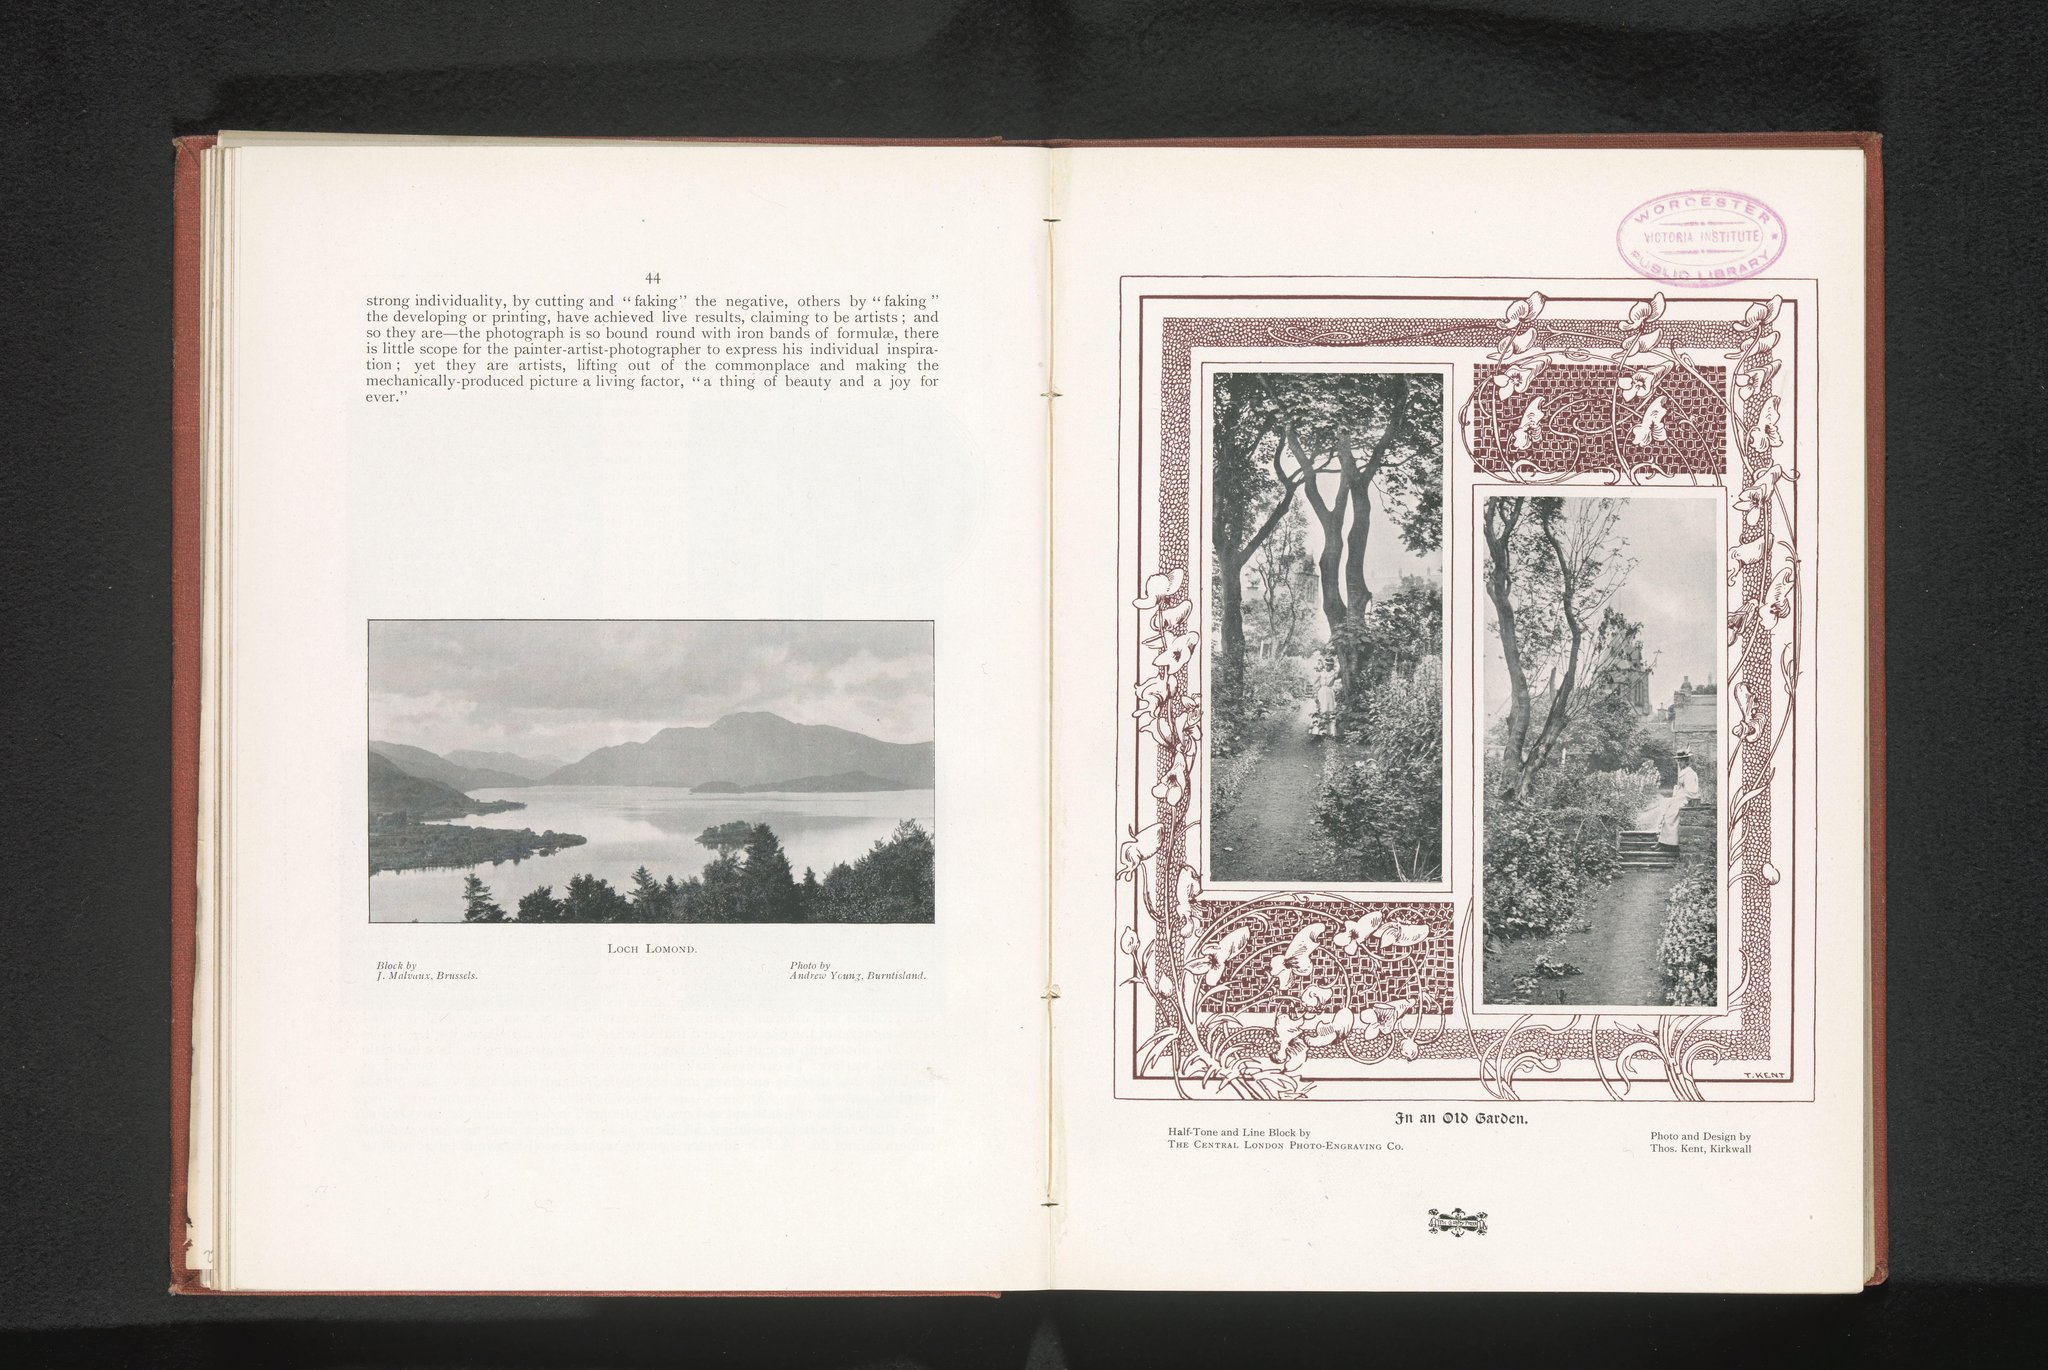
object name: photomechanical print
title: In an old garden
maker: t. kent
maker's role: fotograaf, illustrator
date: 1895-1900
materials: paper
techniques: printing block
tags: adult woman, garden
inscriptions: collector's mark: ‘Worcester Public Library/ Victoria Institute’